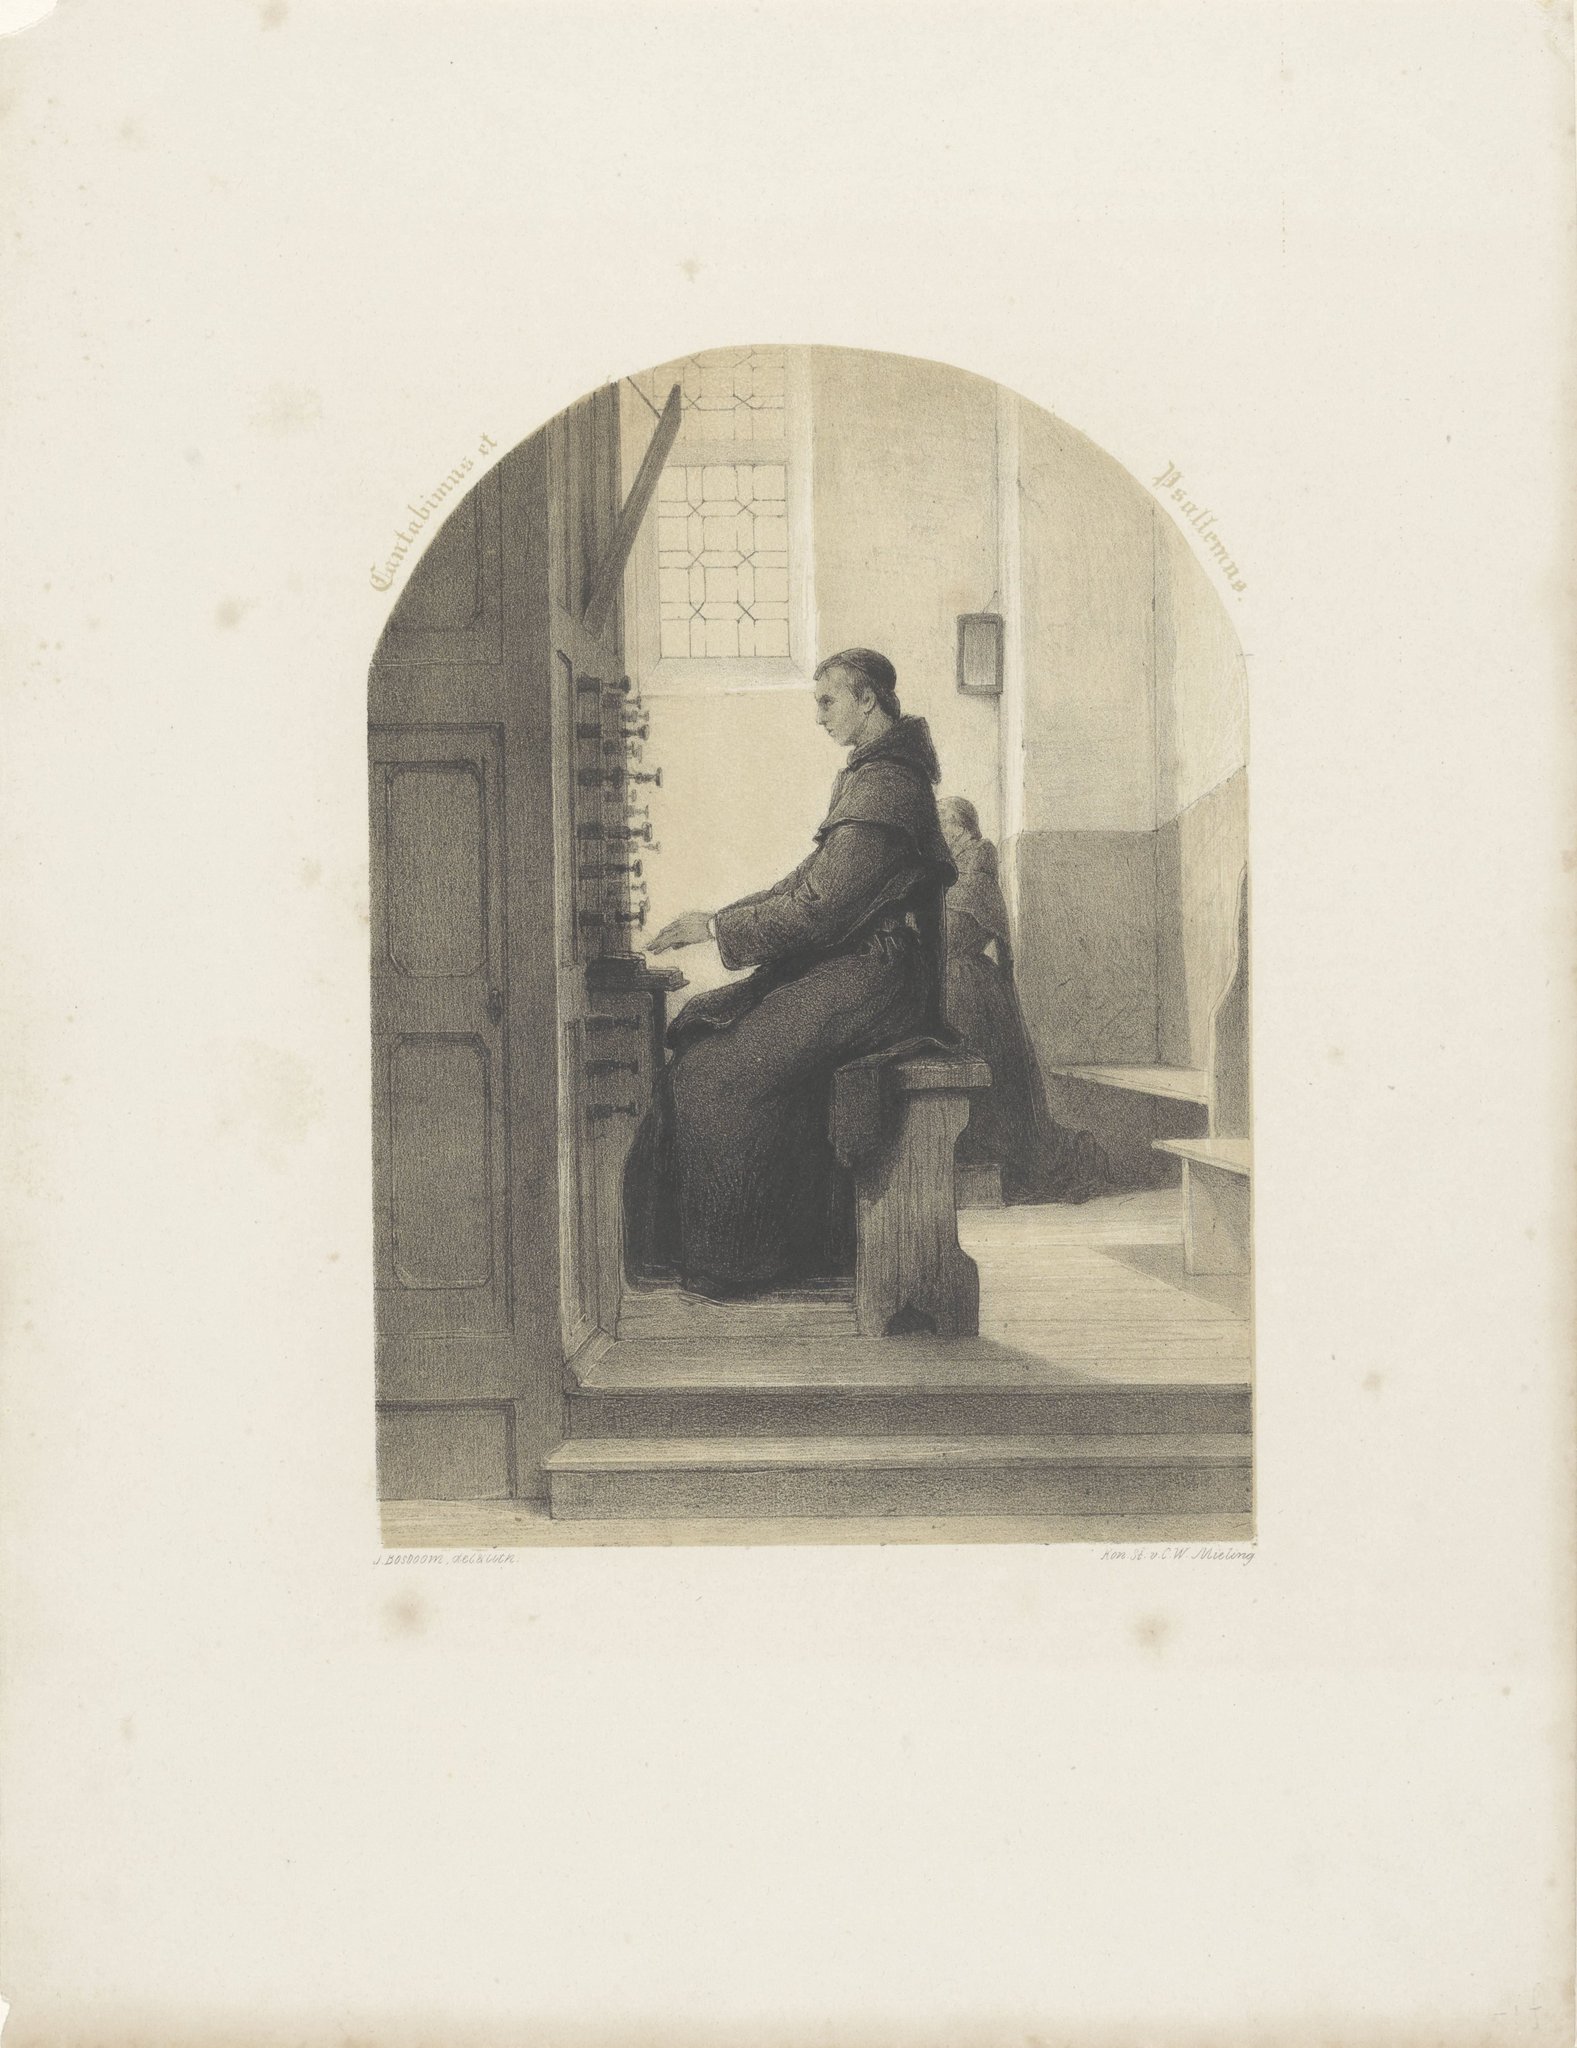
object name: print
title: Monnik aan het orgel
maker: johannes bosboom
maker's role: draughtsman, painter, print maker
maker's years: 1817-1891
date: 1847-1891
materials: paper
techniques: tone lithography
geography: the hague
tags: monk(s), friar(s), church organ, one person praying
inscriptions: collector's mark: Lugt 2228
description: De monnik bespeelt het orgel. Achter hem zit een tweede geeestelijke geknield in een kerkbank. Boven de afbeelding de woorden: Cantabimus et psallemus.